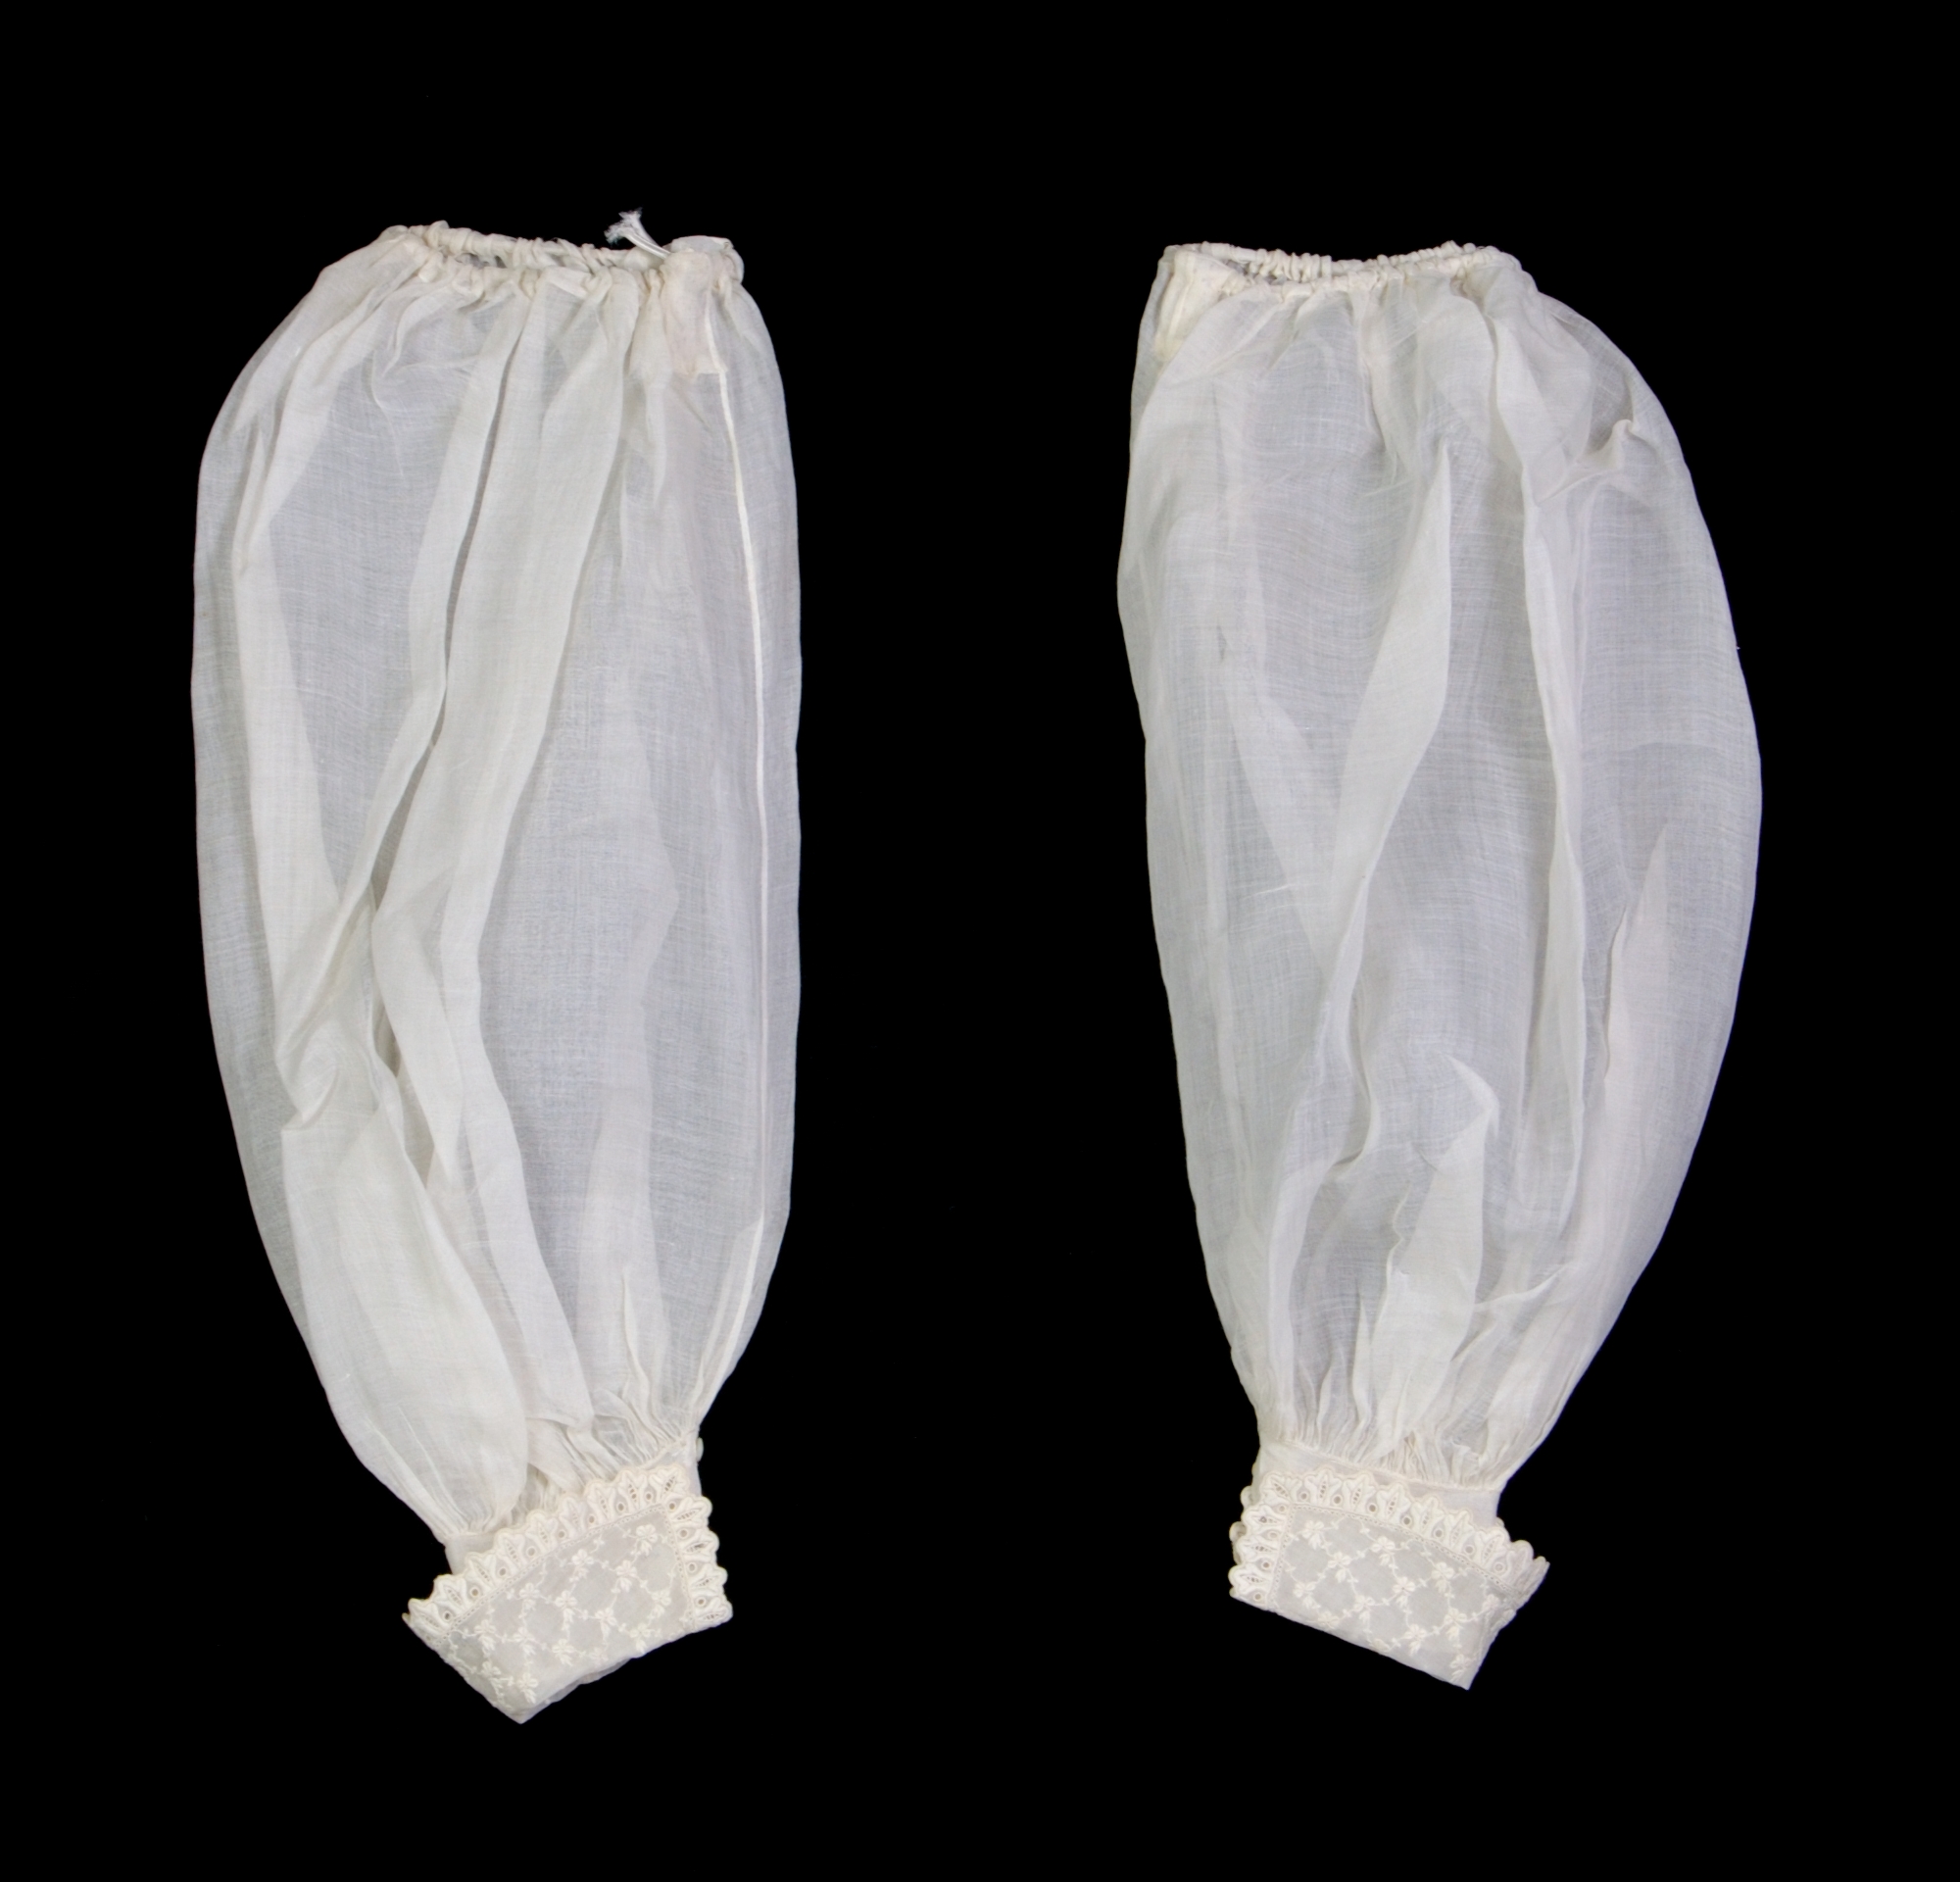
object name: undersleeves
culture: american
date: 1855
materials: cotton